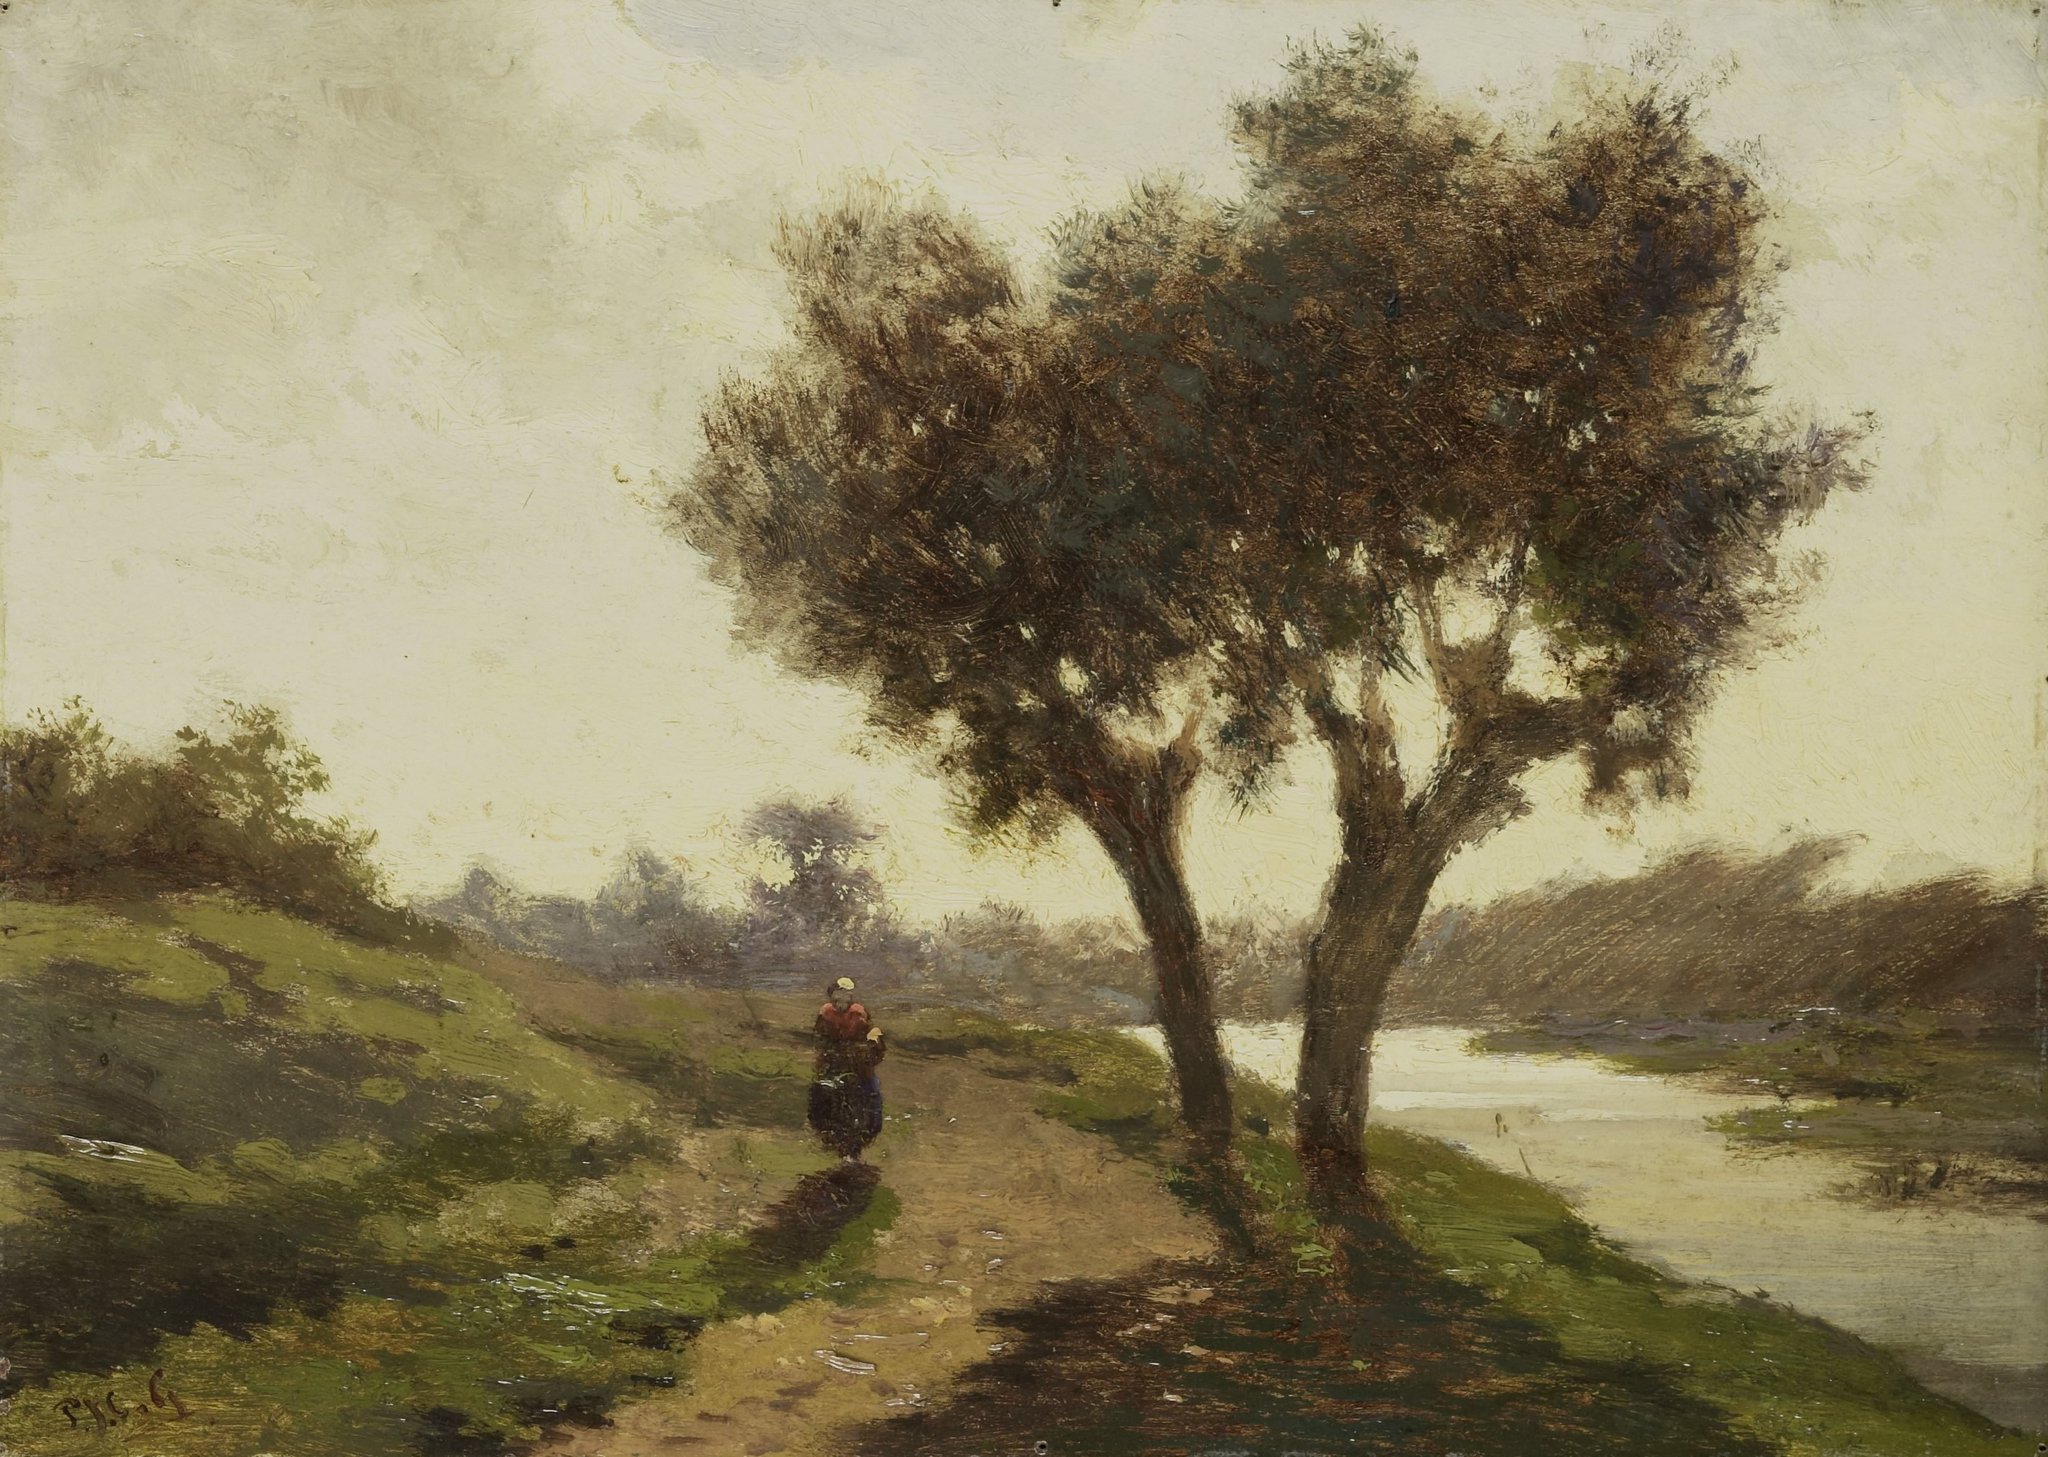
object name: painting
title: Landscape with two Trees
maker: paul joseph constantin gabriël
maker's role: draughtsman, print maker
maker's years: 1828-1903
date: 1860-1867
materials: oil, panel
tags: landscapes in the temperate zone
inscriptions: label: ‘A mon Ami H. Hymans, de la part de P.J.C. Gabriël, Bruxelles le 4[?] Janv: 1867’, signature: ‘P.J.C.G.’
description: Landschap met een vrouw bij twee bomen op een pad langs het water.